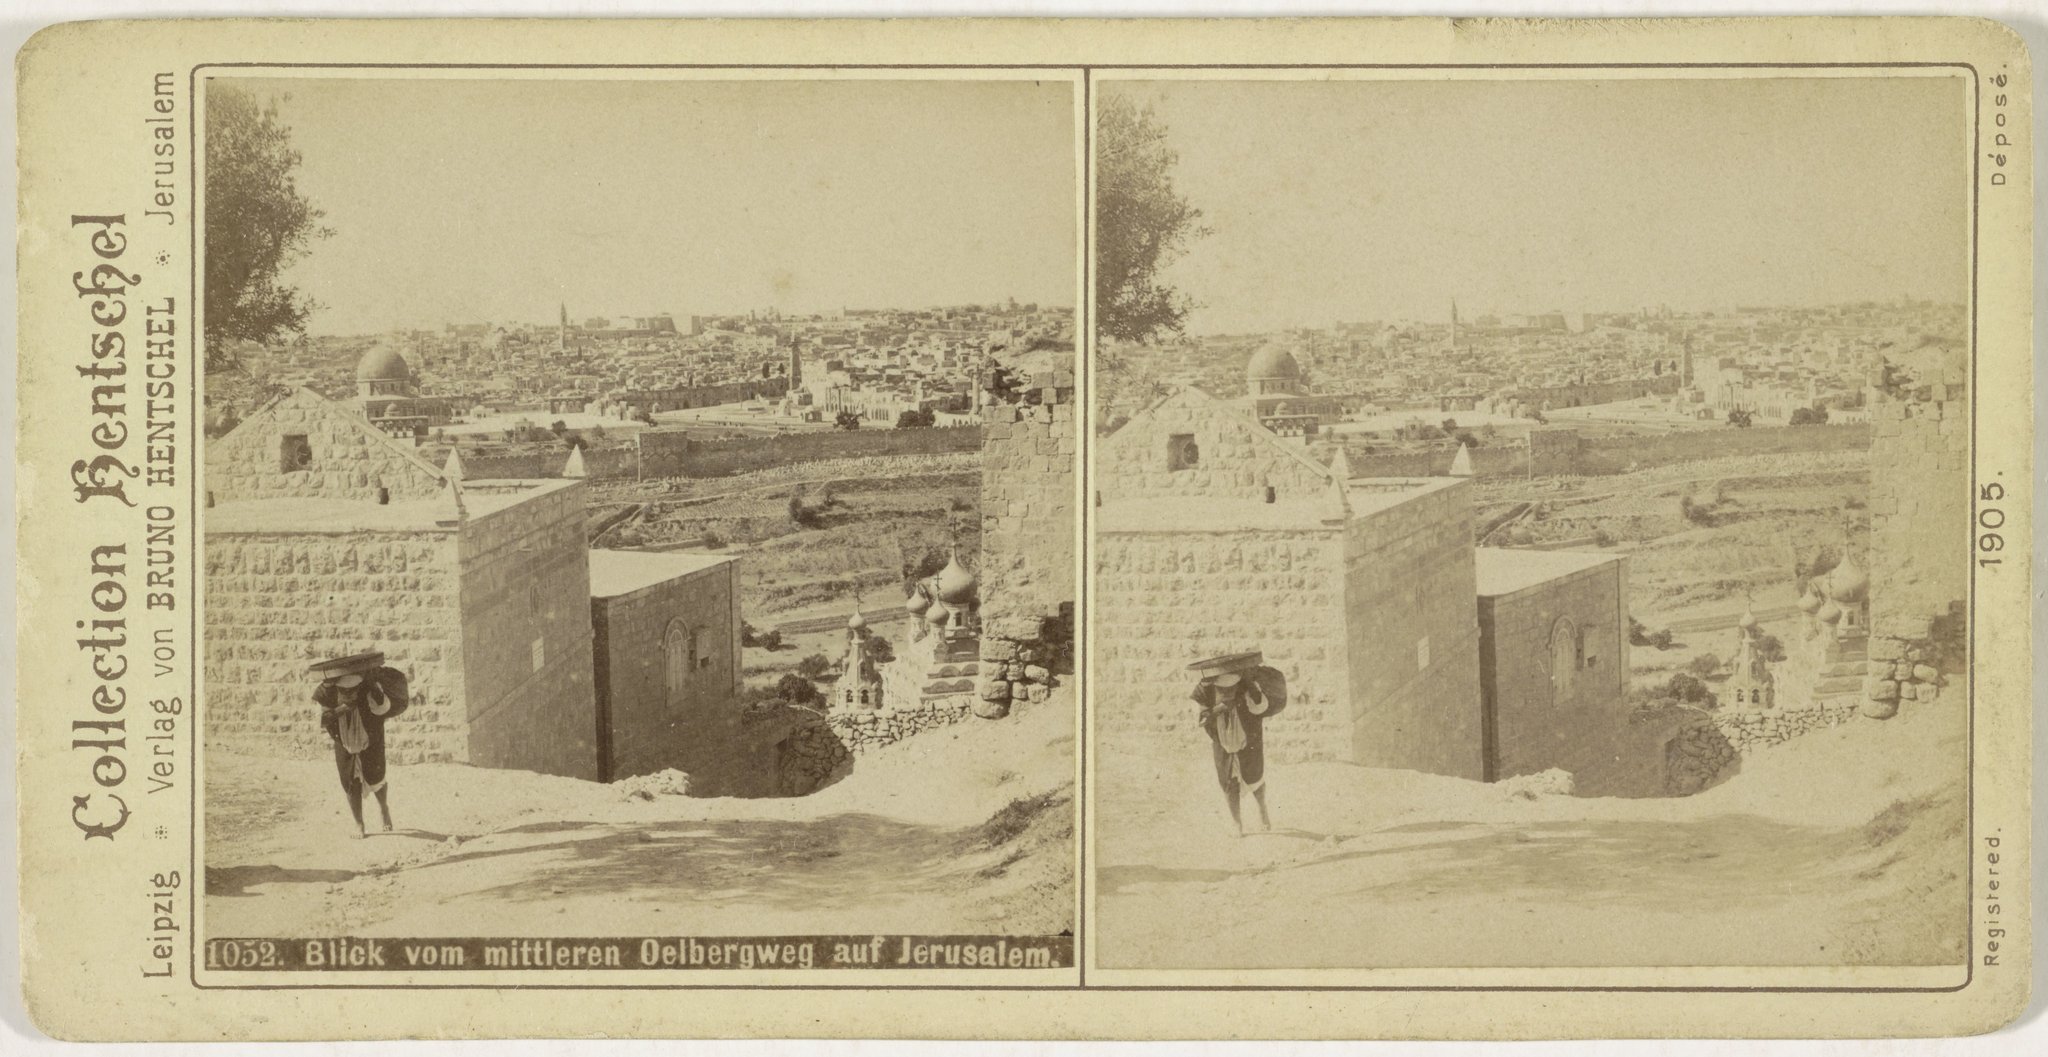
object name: stereograph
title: Blick vom mittleren Oelbergweg auf Jerusalem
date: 1905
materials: cardboard, paper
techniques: albumen print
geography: olijfberg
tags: city-view in general; 'veduta'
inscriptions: inscription: ‘Déposé.’, inscription: ‘Registered.’, number: ‘1052.’